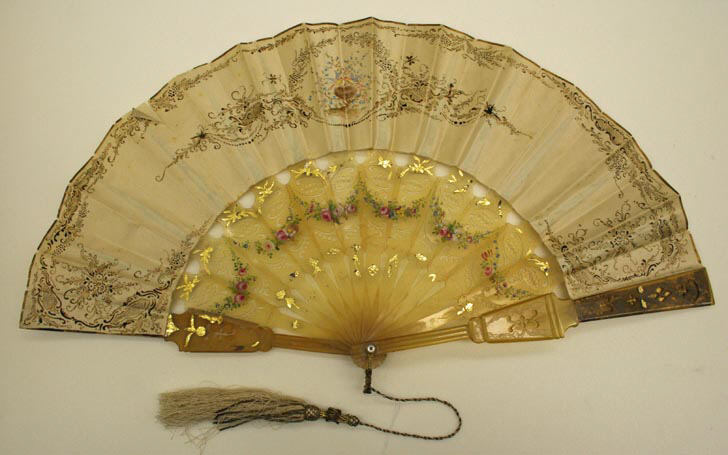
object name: fan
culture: french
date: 1846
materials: horn, mother of pearl, silk